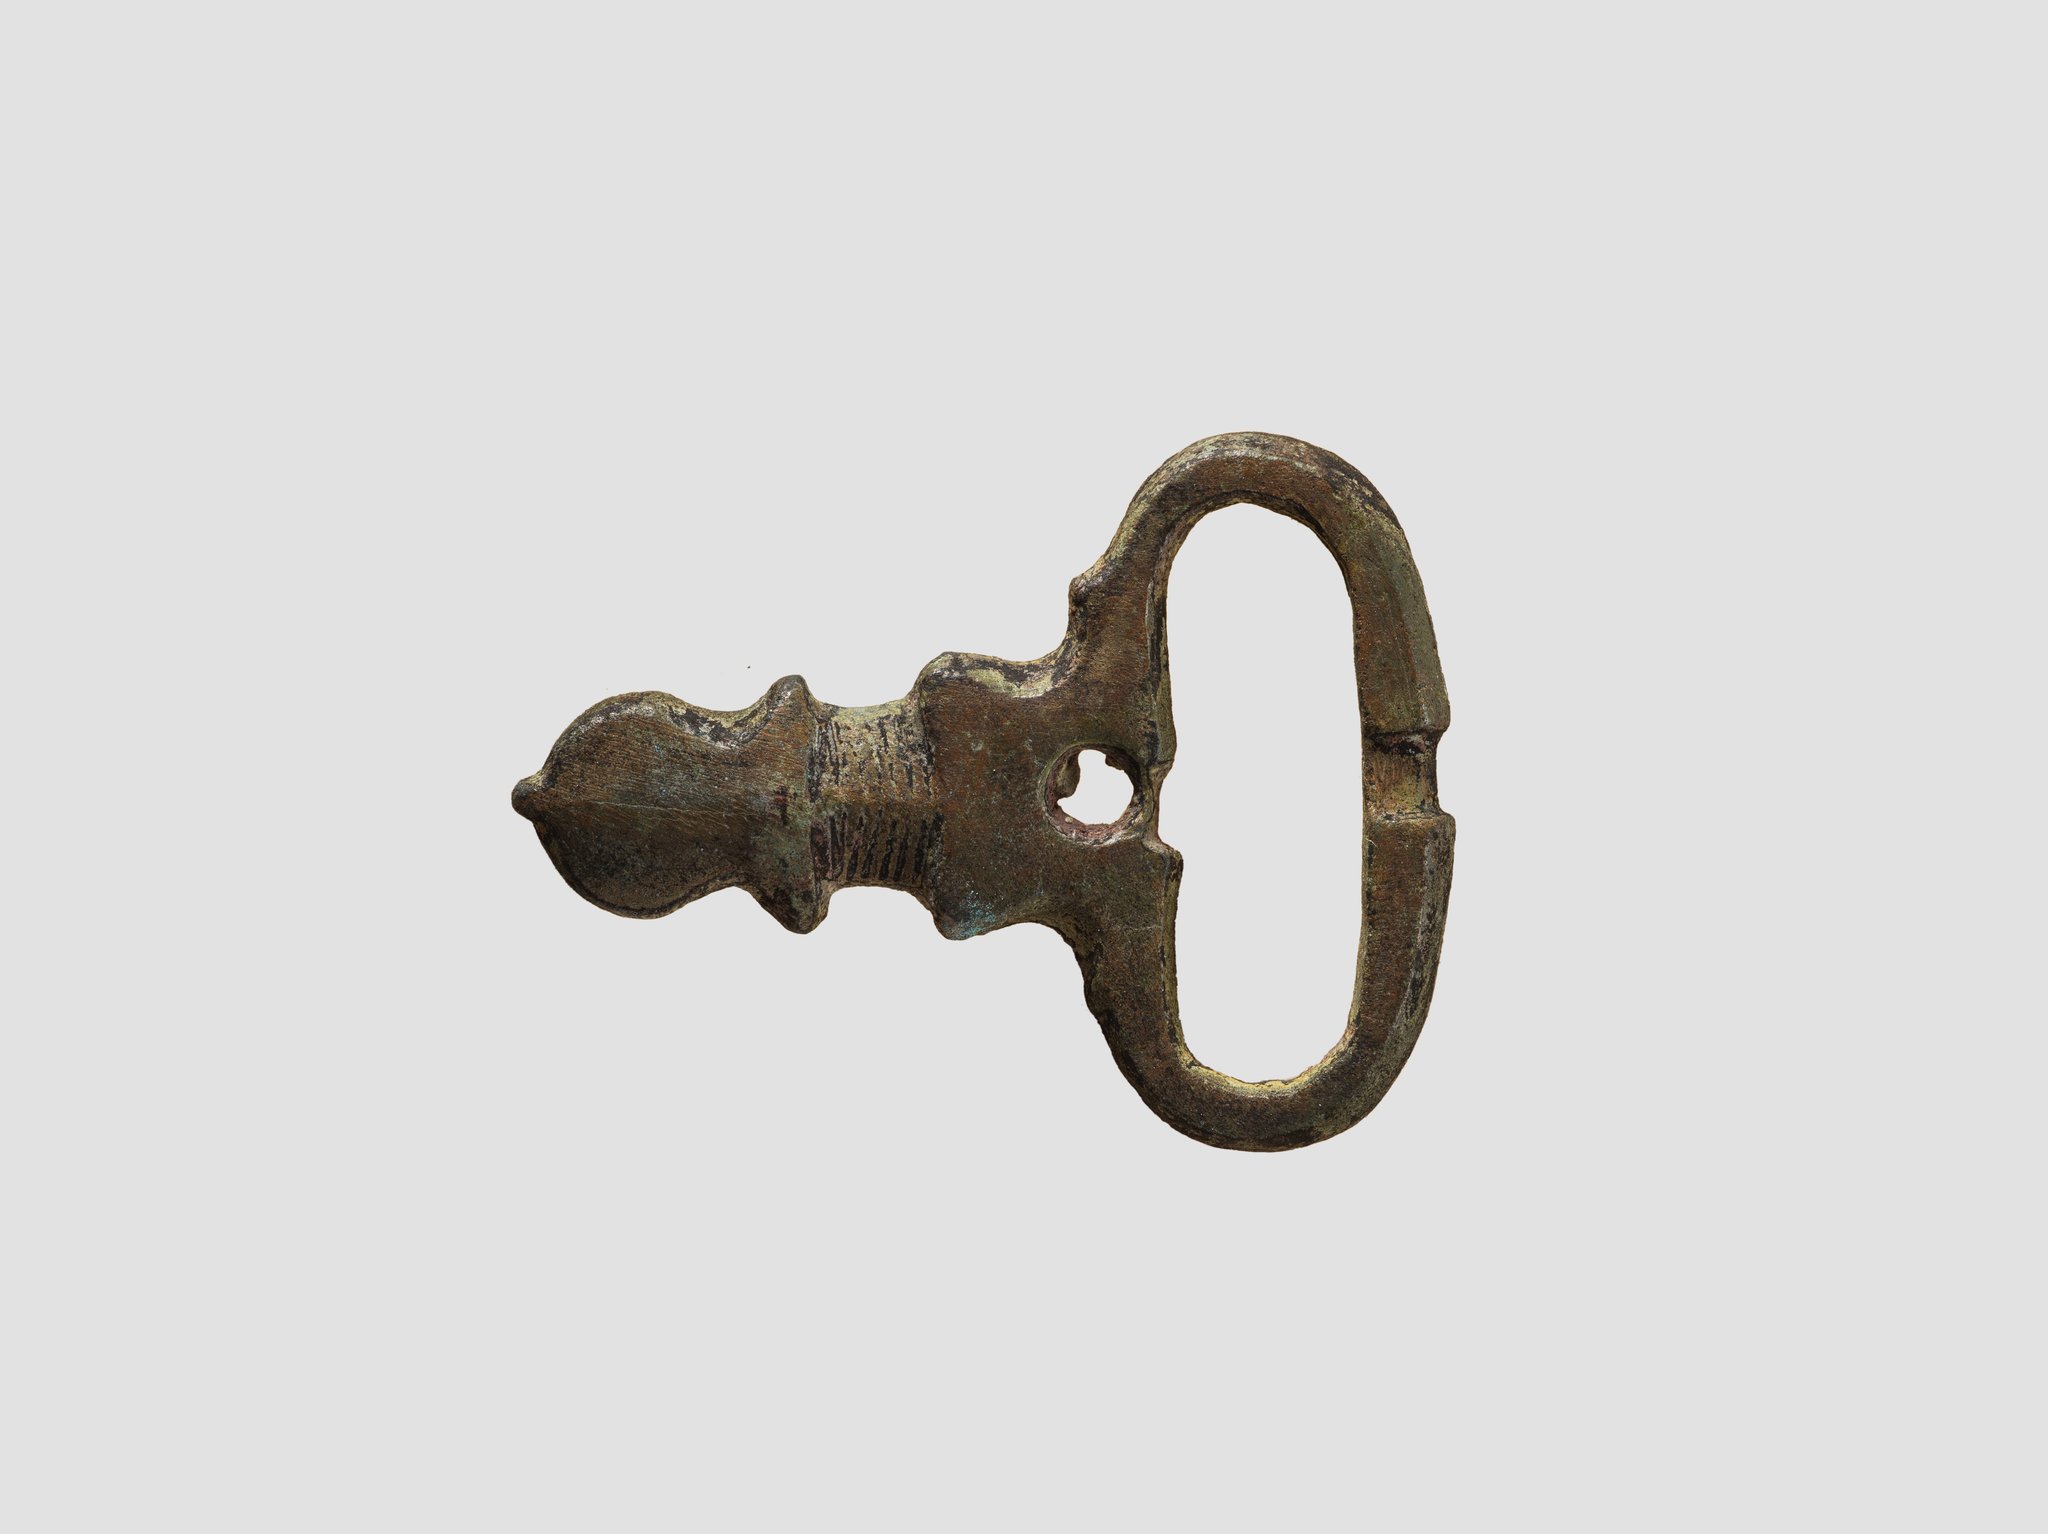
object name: belt buckle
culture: sasanian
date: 201-700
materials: bronze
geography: iran